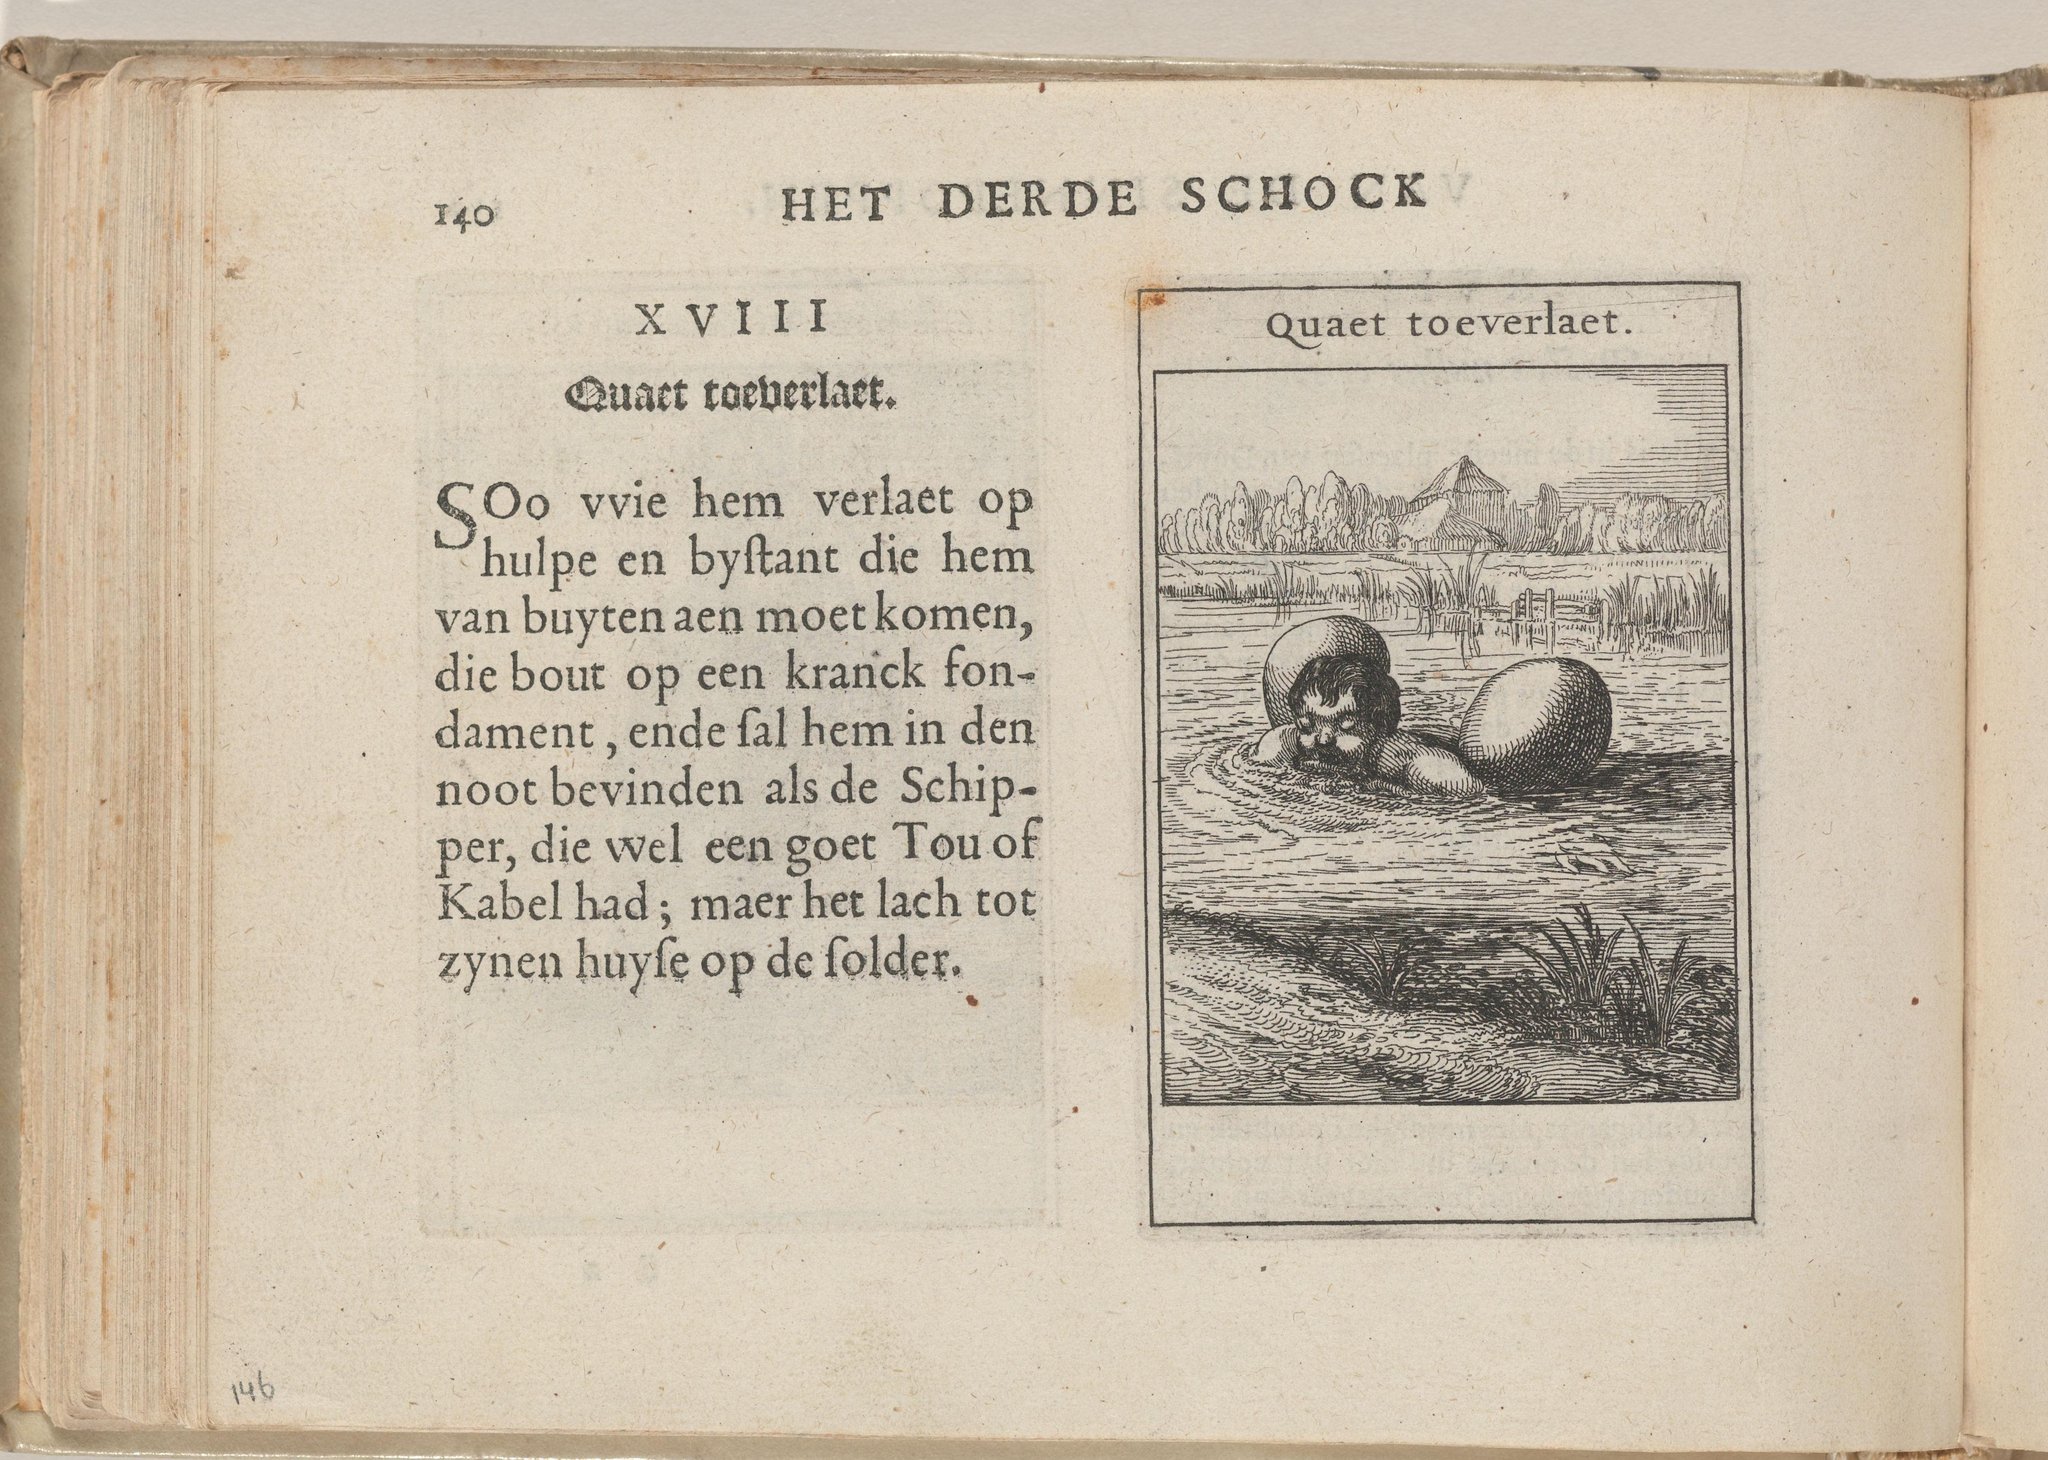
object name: album leaf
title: XVIII Quaet toeverlaet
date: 1614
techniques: engraving, printing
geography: the hague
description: XVIII Quaet toeverlaet. Derde schok. Onderdeel van 'Sinnepoppen', R. Visscher, 1614.